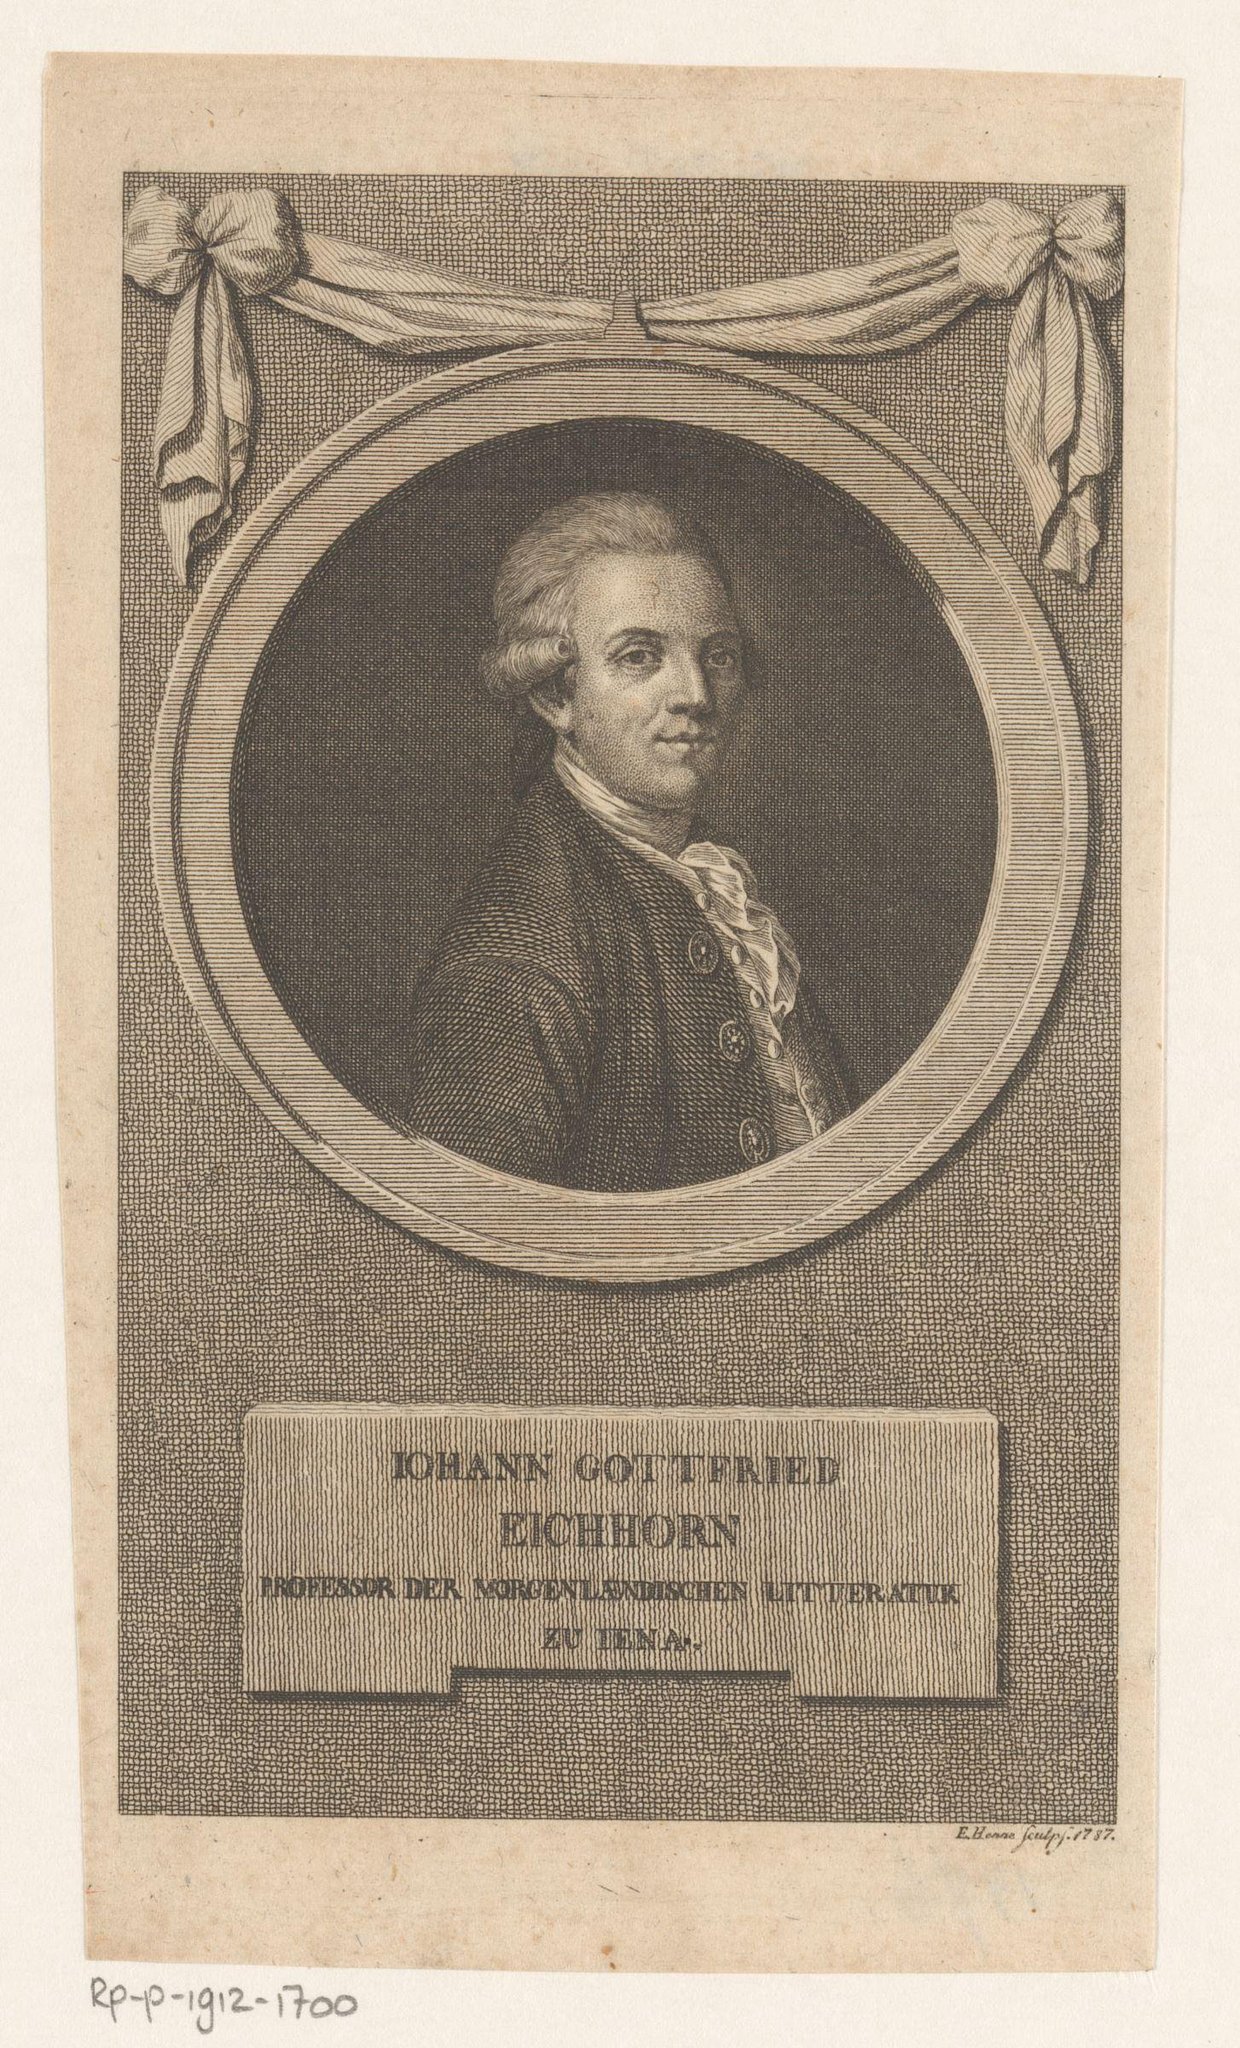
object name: print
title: Portret van Johann Gottfried Eichhorn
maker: eberhard siegfried henne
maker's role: print maker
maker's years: 1759-1828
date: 1769-1827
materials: paper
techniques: engraving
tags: theologian, historical persons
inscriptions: collector's mark: Lugt 2228